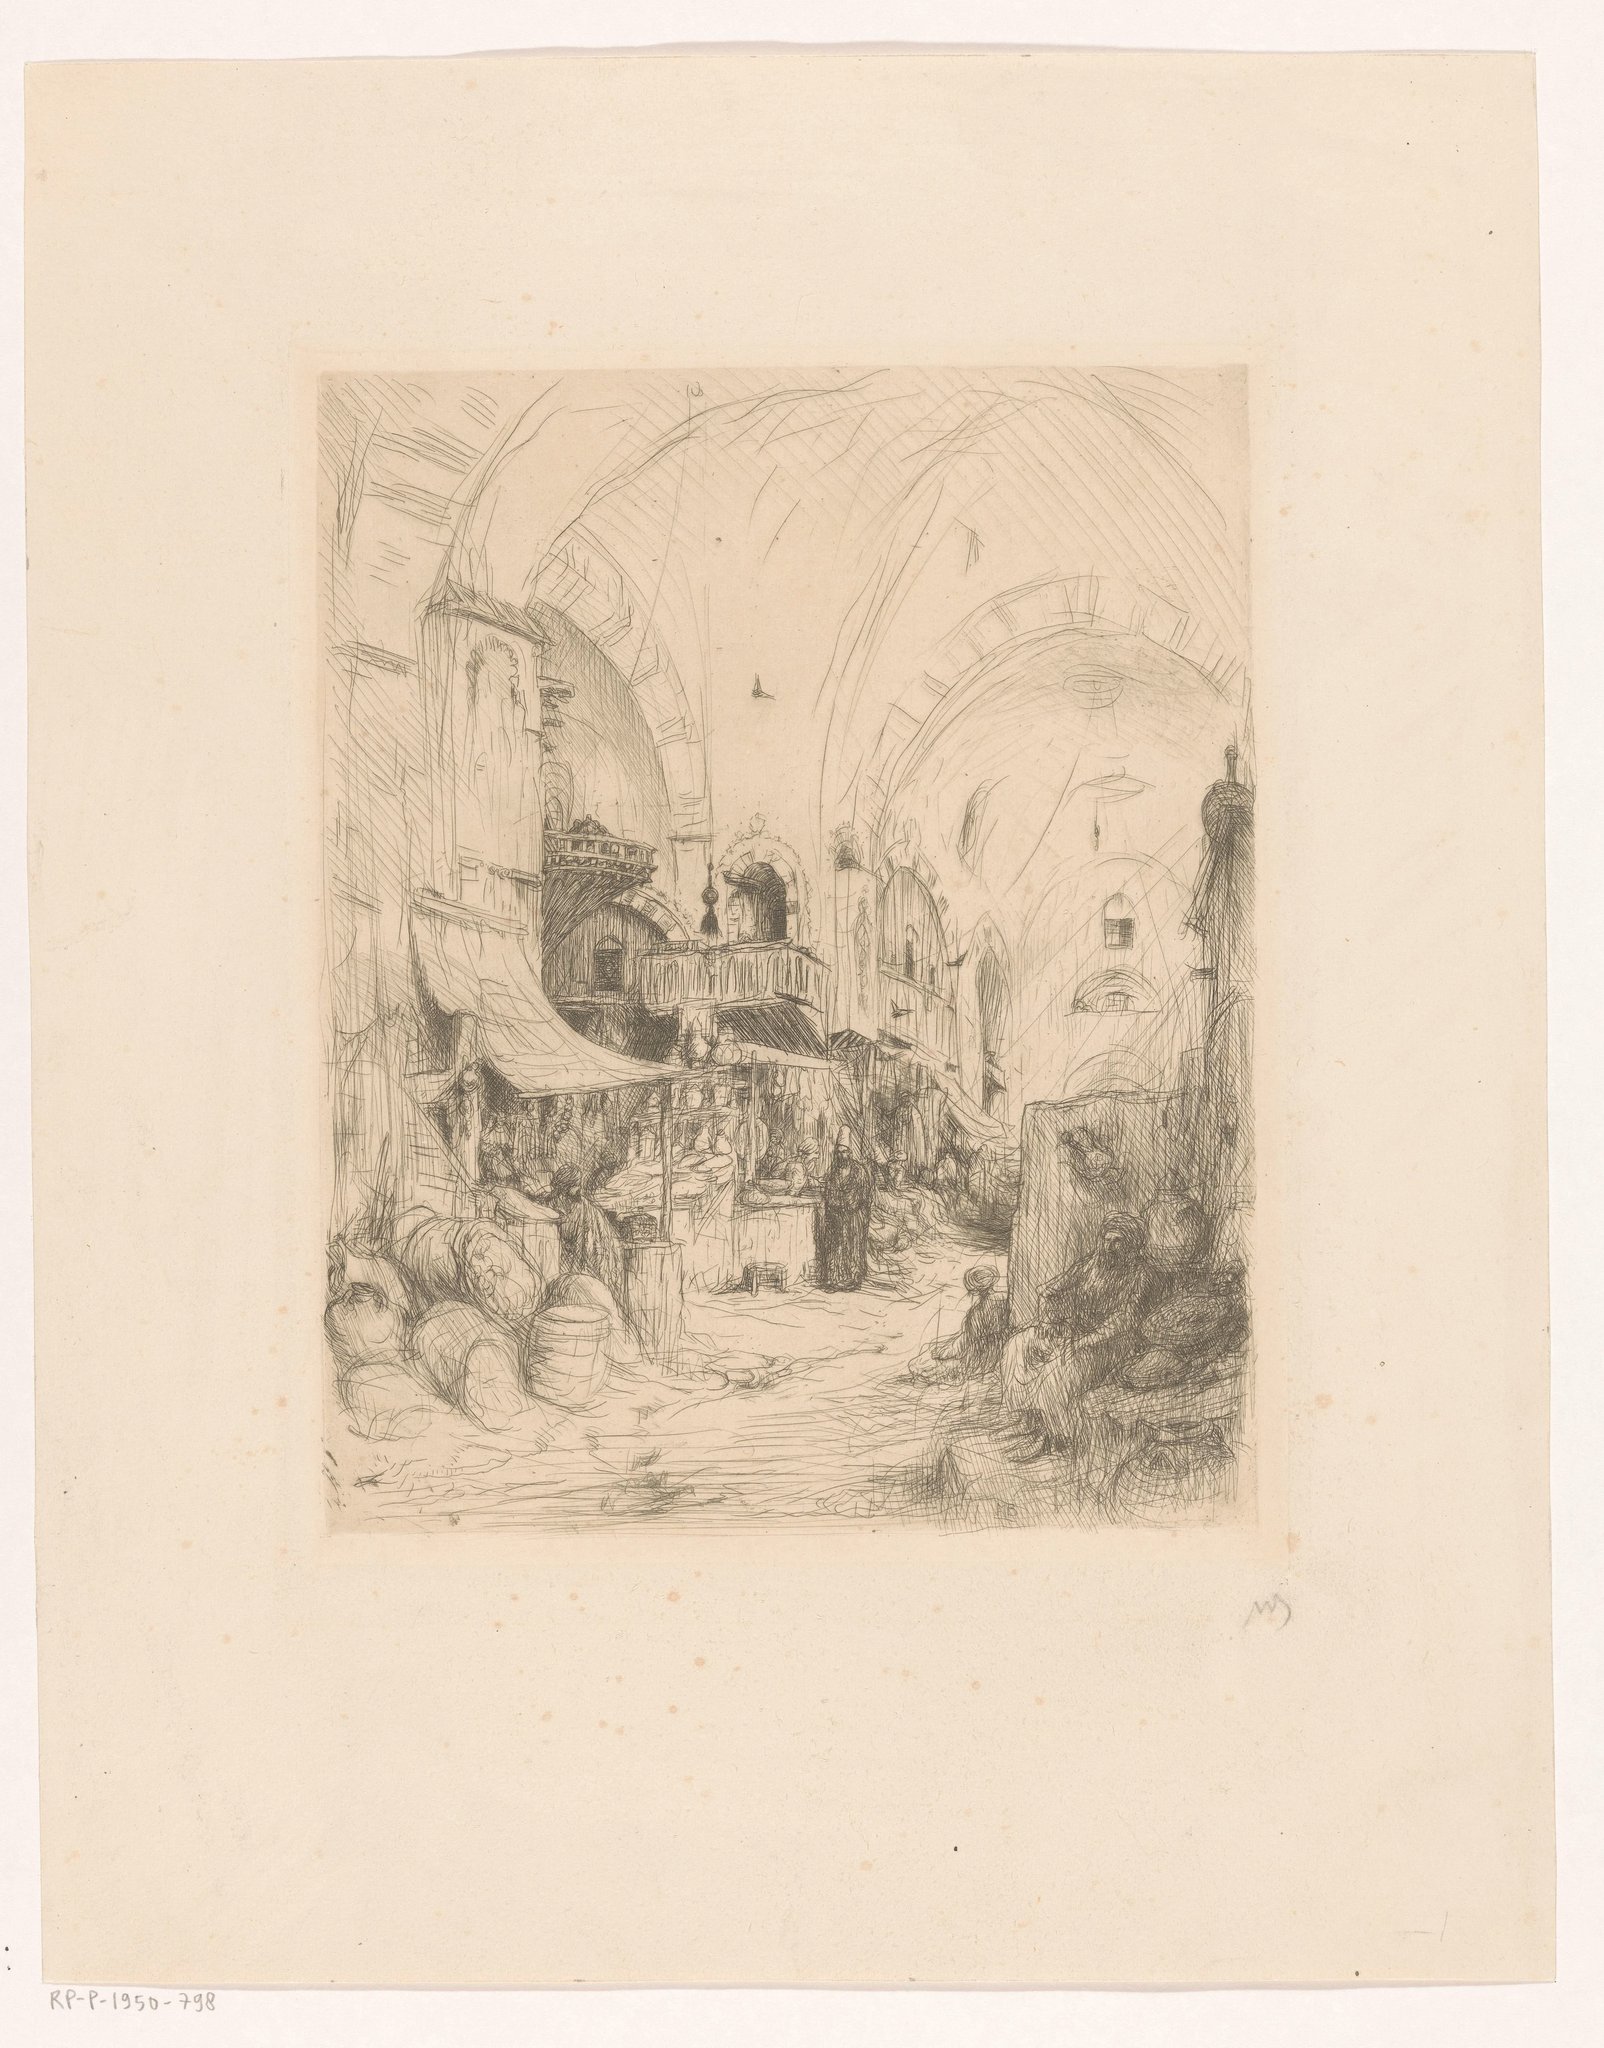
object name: print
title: Bazaar in Constantinopel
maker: marius bauer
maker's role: draughtsman, print maker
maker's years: 1867-1932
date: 1877-1932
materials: paper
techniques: etching, intaglio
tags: market-hall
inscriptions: collector's mark: Lugt 2228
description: Figuren op een overdekte bazaar met kramen met uitgestalde waren.